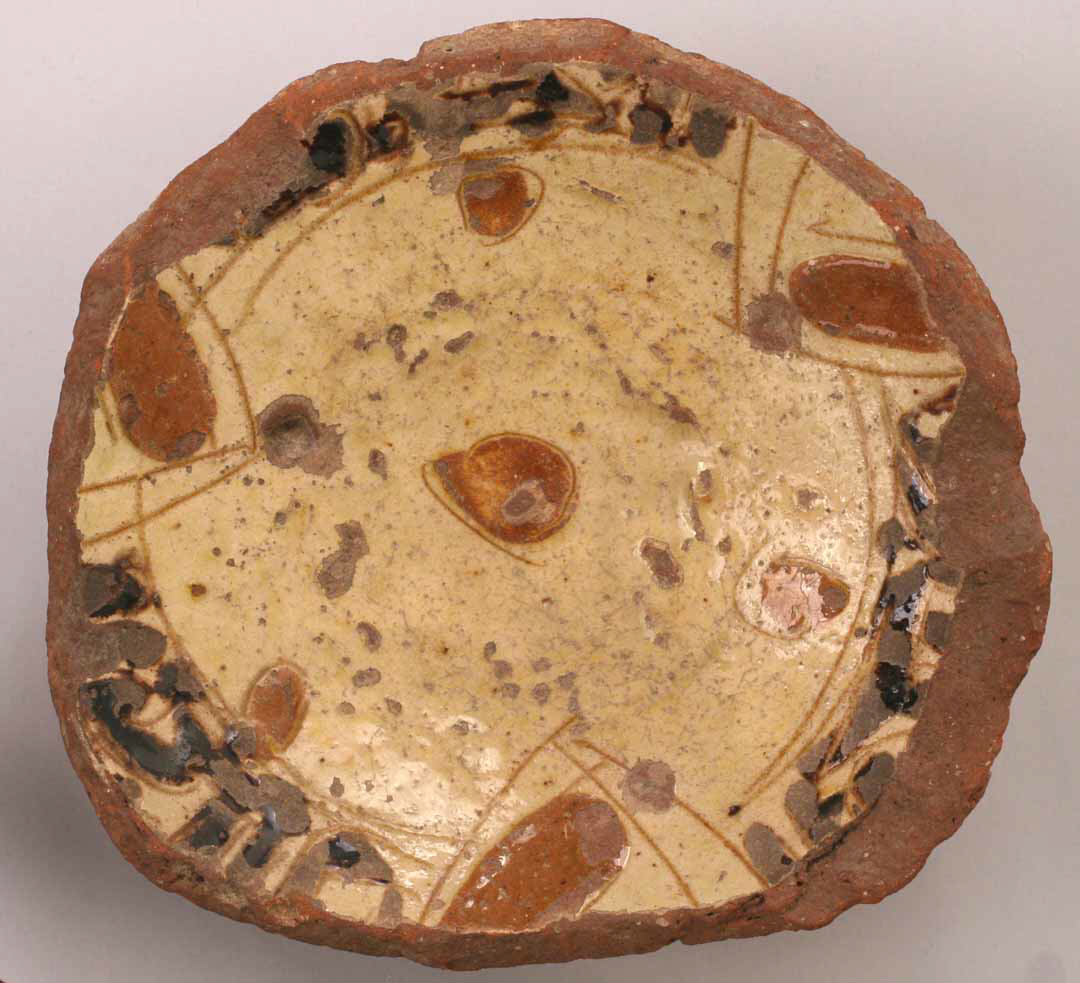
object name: ceramic fragment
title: Fragment of a Bowl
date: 1301-1500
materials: earthenware, glaze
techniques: coloring, incising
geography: egypt